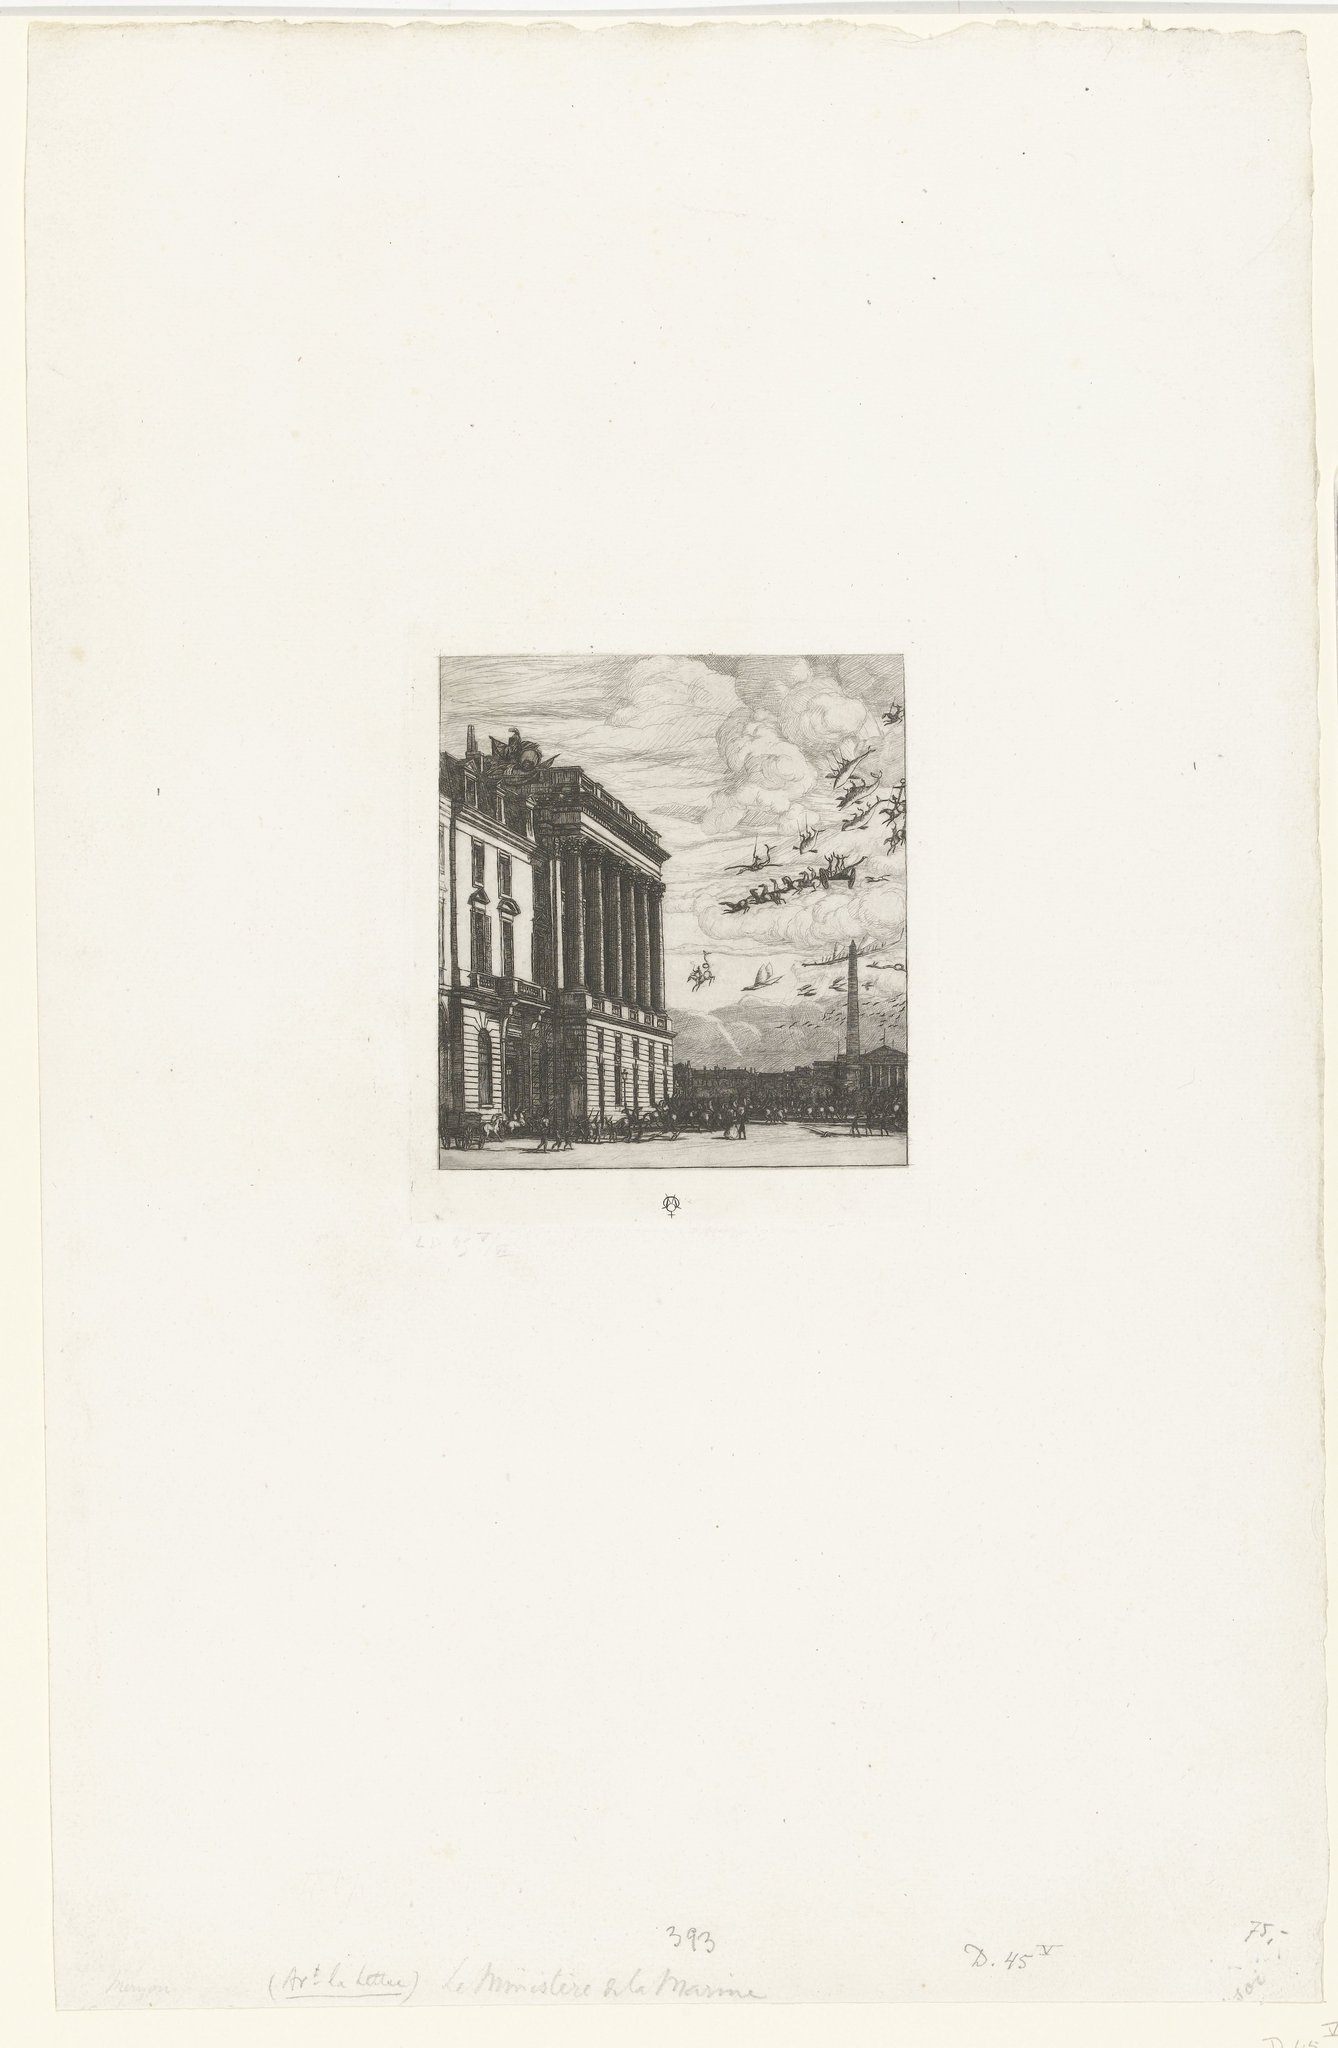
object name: print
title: Ministerie van Marine met fantasie wezens in de lucht boven Parijs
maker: charles meryon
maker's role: print maker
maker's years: 1821-1868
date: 1865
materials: paper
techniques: etching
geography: france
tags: square, place, circus, etc., paris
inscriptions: collector's mark: Lugt 2228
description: Gezicht op het gebouw van het Ministerie van Marine, gezien vanaf de Rue Royale met in de verte rechts de obelisk op de Place de la Concorde in Parijs. In de lucht vliegen allerlei fantasie wezens zoals vissen en paarden die worden gadegeslagen door toeschouwers op het plein voor het ministerie.